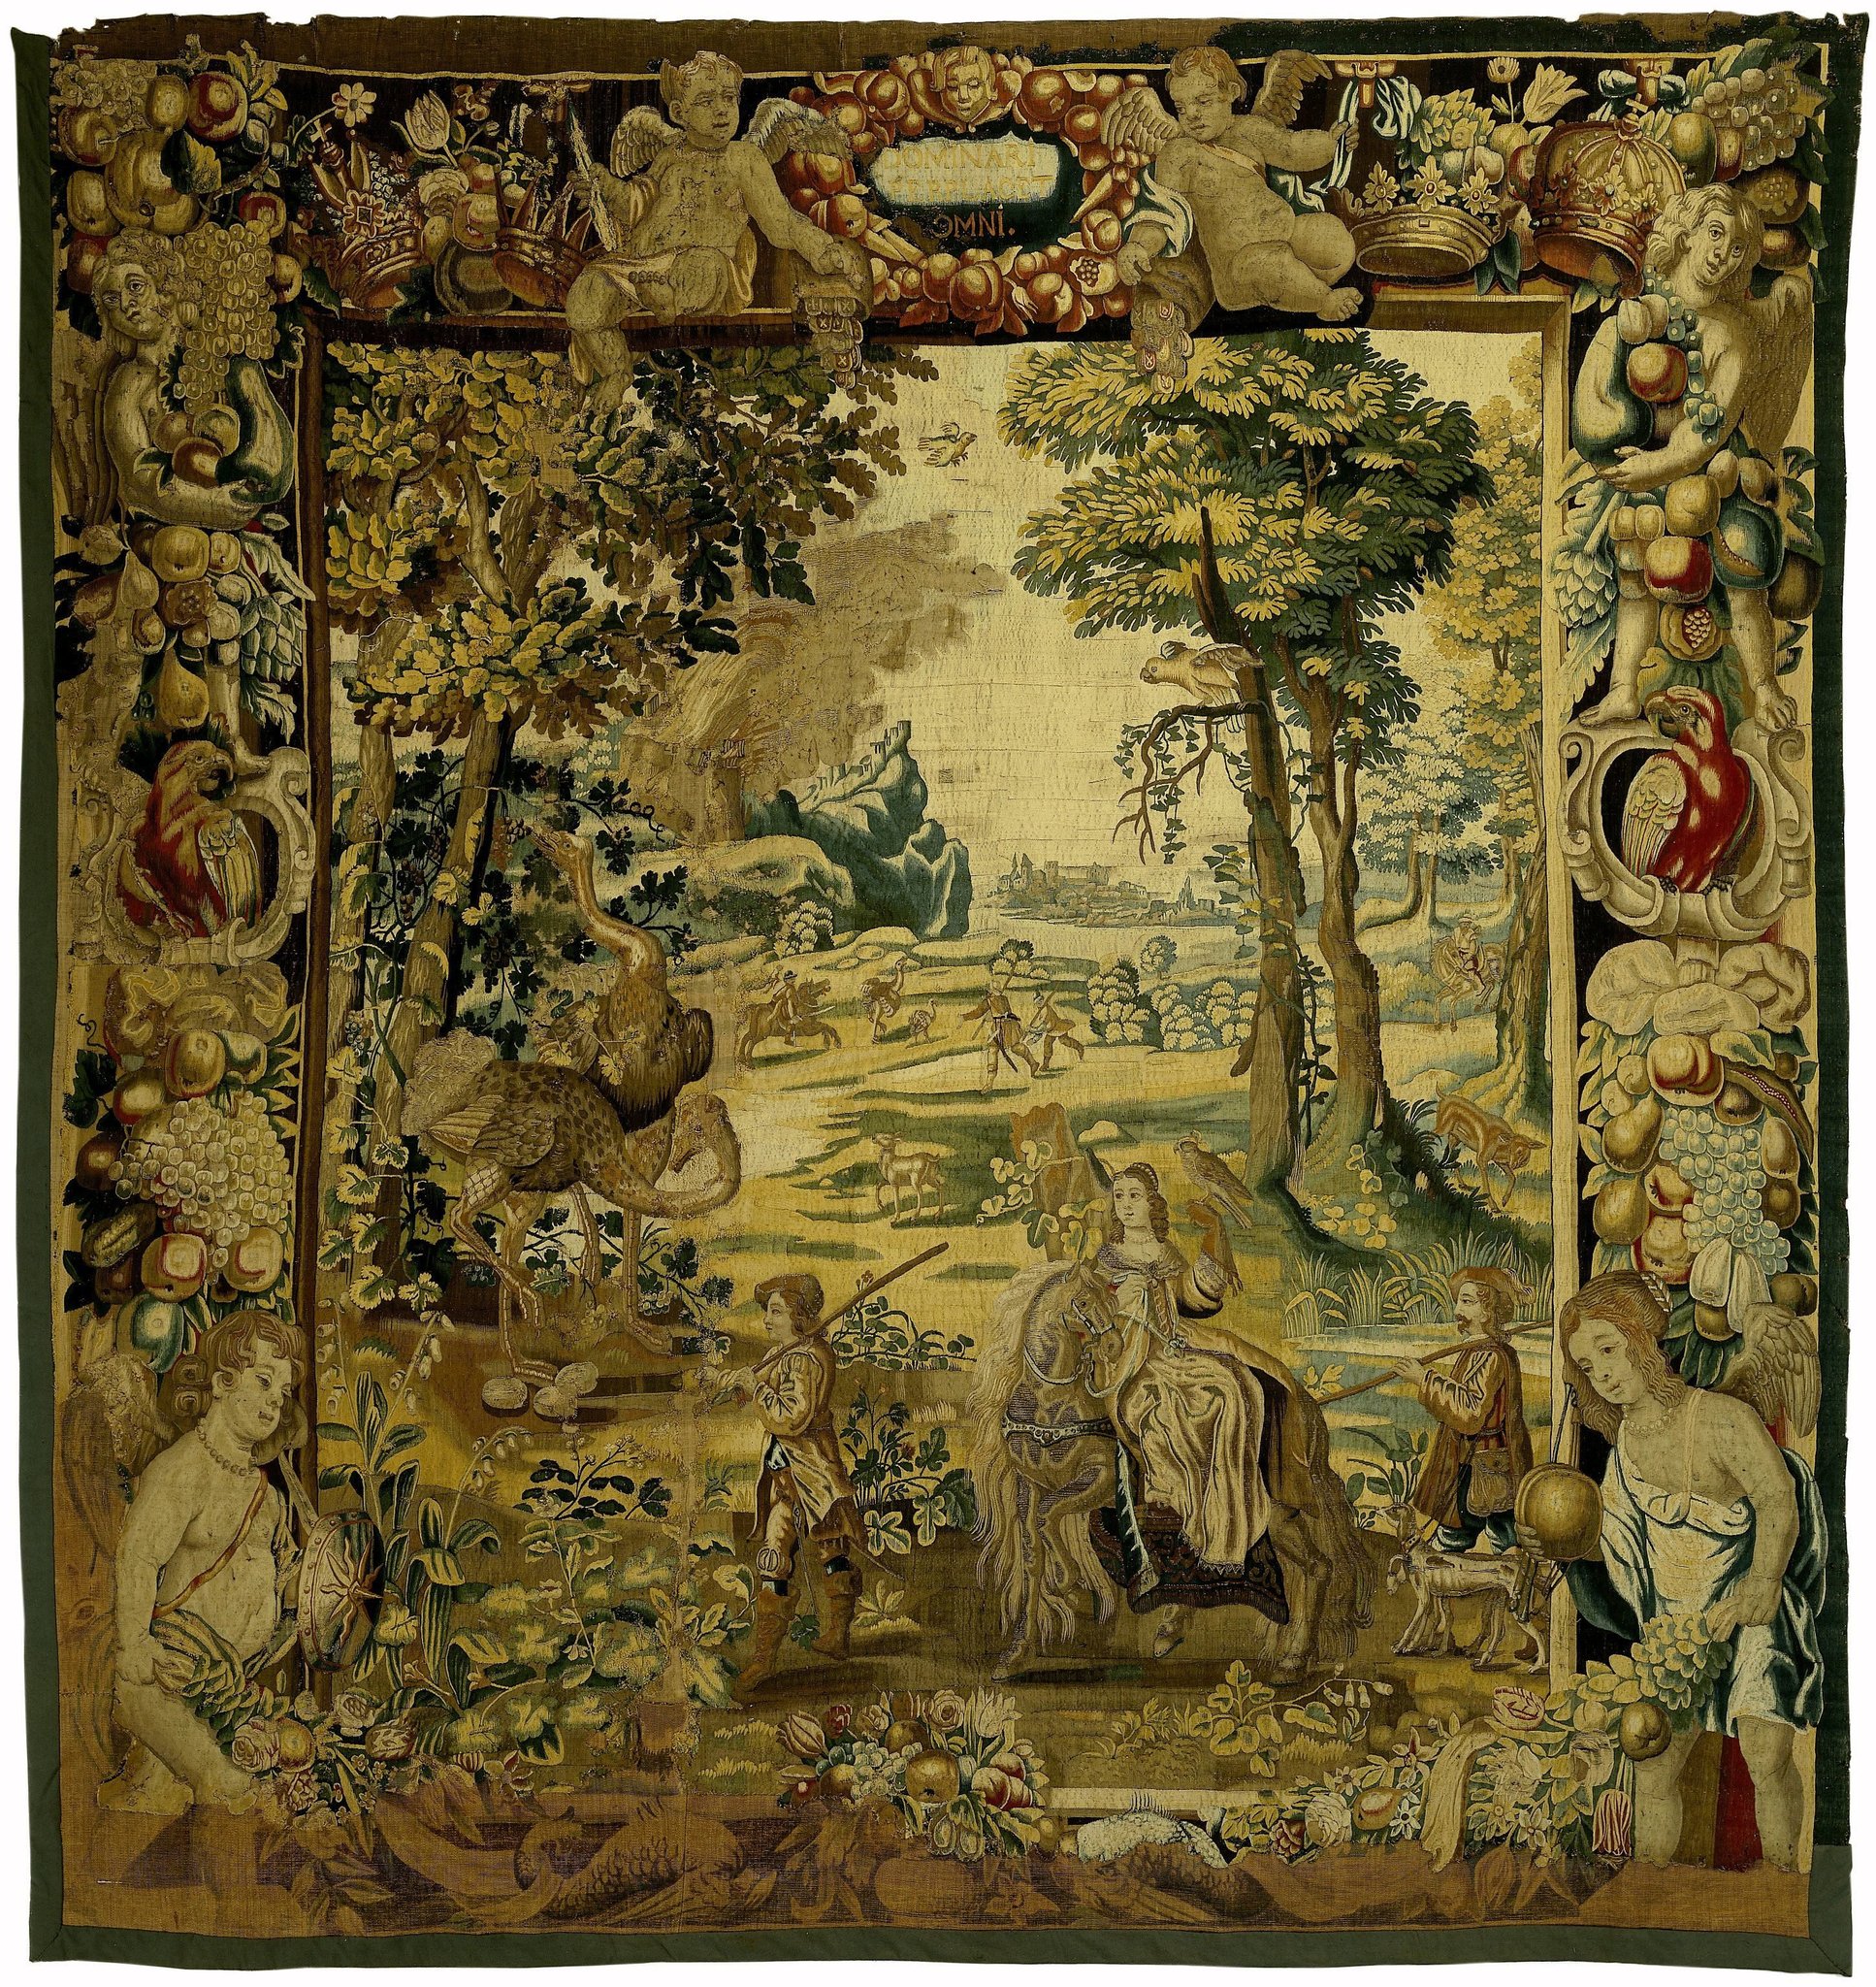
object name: tapestry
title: Landschapsverdure met struisvogels en jachtscènes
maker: erasmus oorlofs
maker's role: wever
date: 1650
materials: silk, wool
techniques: tapestry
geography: brussels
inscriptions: inscription: ‘DOMINARI PERPLACIT OMNI’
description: Wandtapijt met struisvogeljacht en de spreuk "dominari perplacet omni". (Uit een serie)